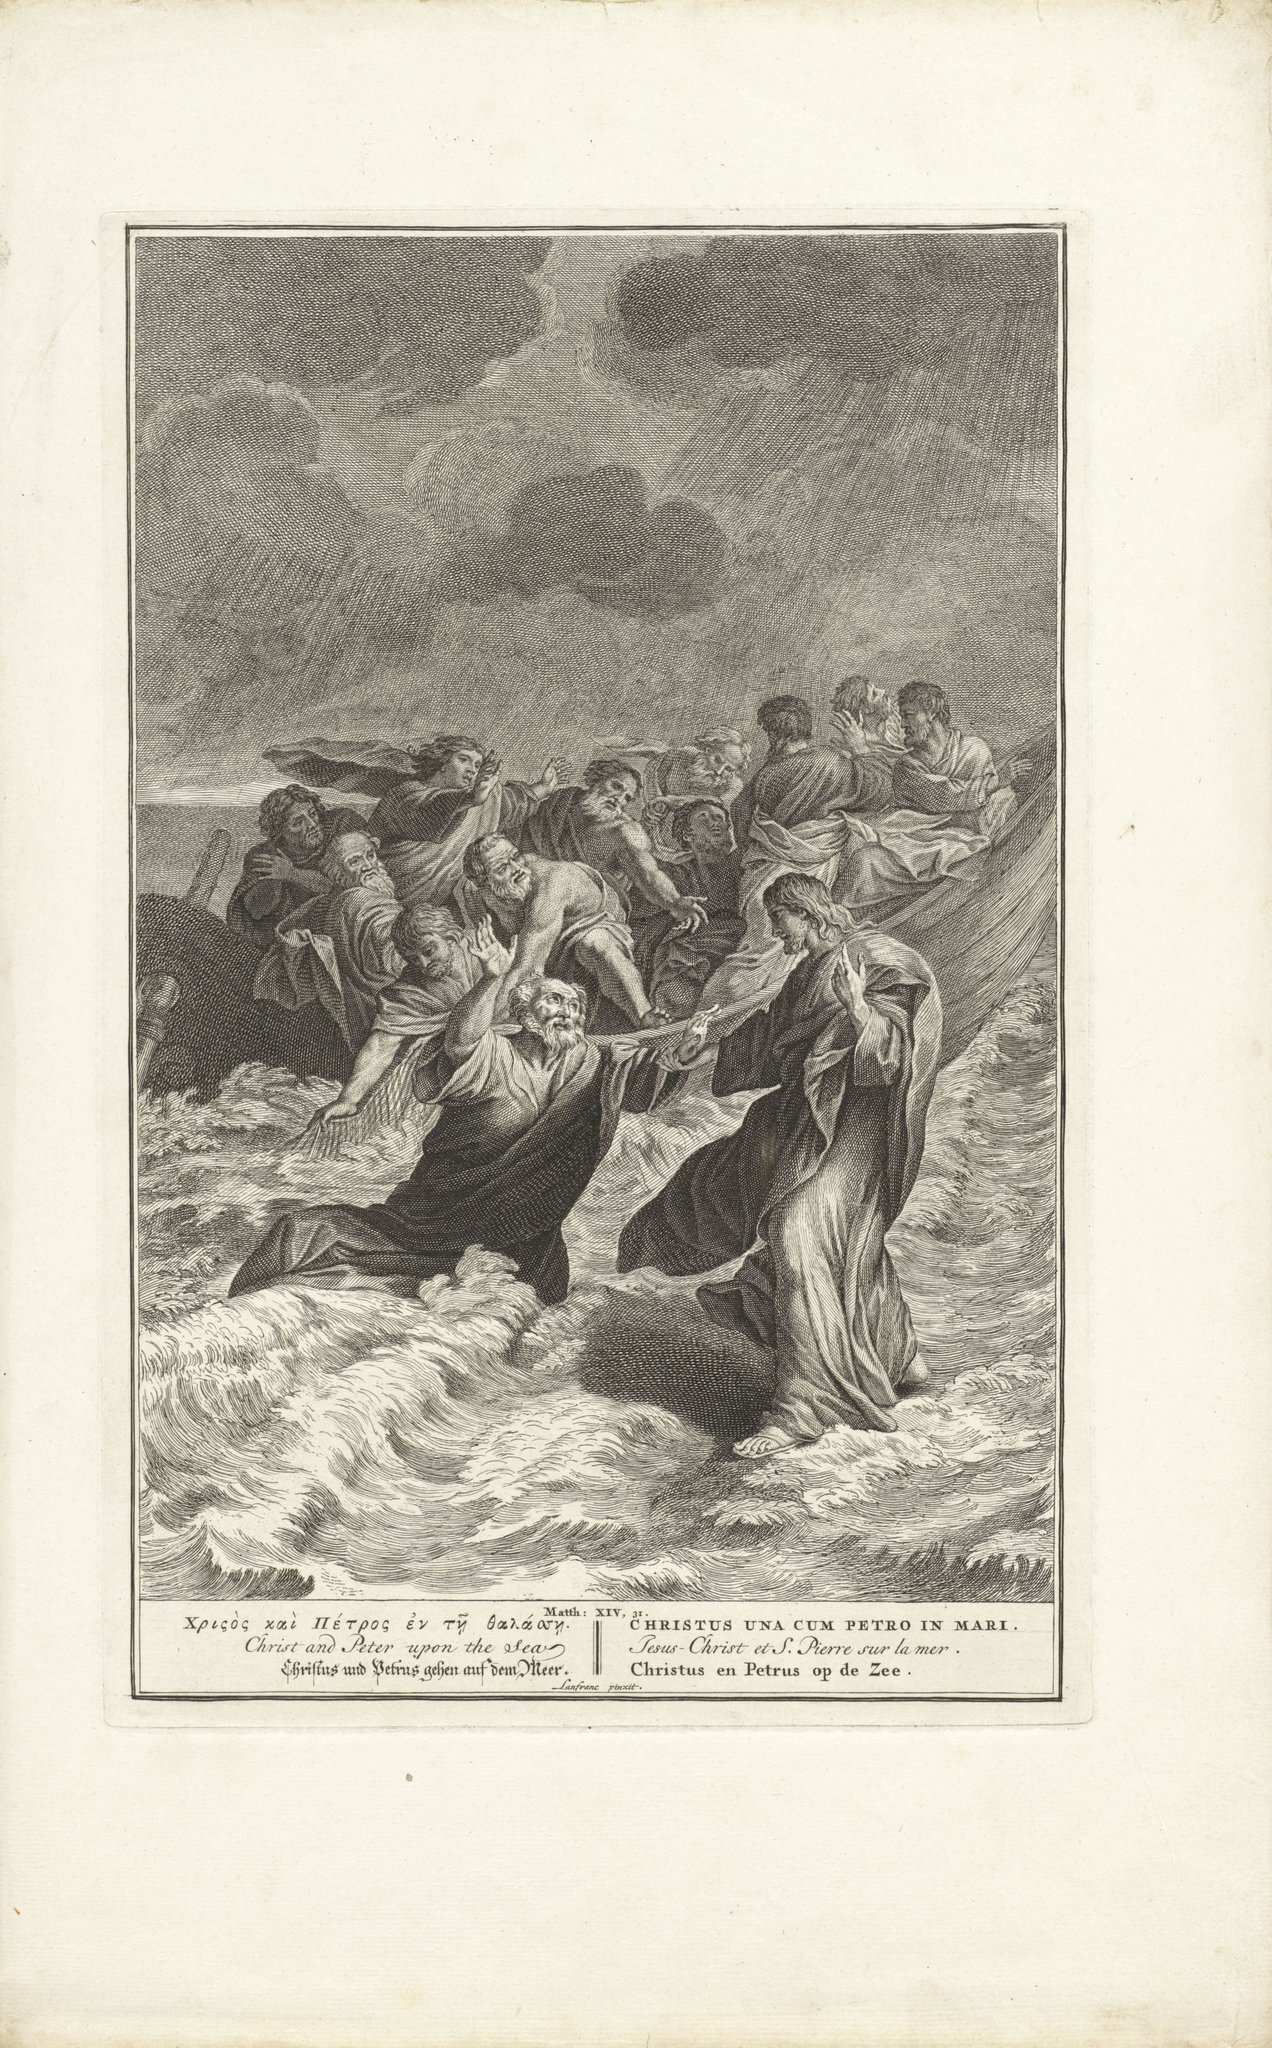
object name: print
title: Christus redt Petrus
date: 1602-1697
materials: paper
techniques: engraving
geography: italy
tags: christ saves peter from drowning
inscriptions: collector's mark: Lugt 2228, inscription: ‘Utrechts Fundatie huijs’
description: In stormachtig weer probeert Petrus over het water naar Christus toe te lopen. Christus redt hem door zijn hand vast te pakken. Op de achtergrond een boot. Onder een éénregelige toelichting in het Oudgrieks, Engels, Duits, Latijn, Frans en Nederlands. Daarboven een verwijzing naar de Bijbeltekst in Mat. 14: 31.